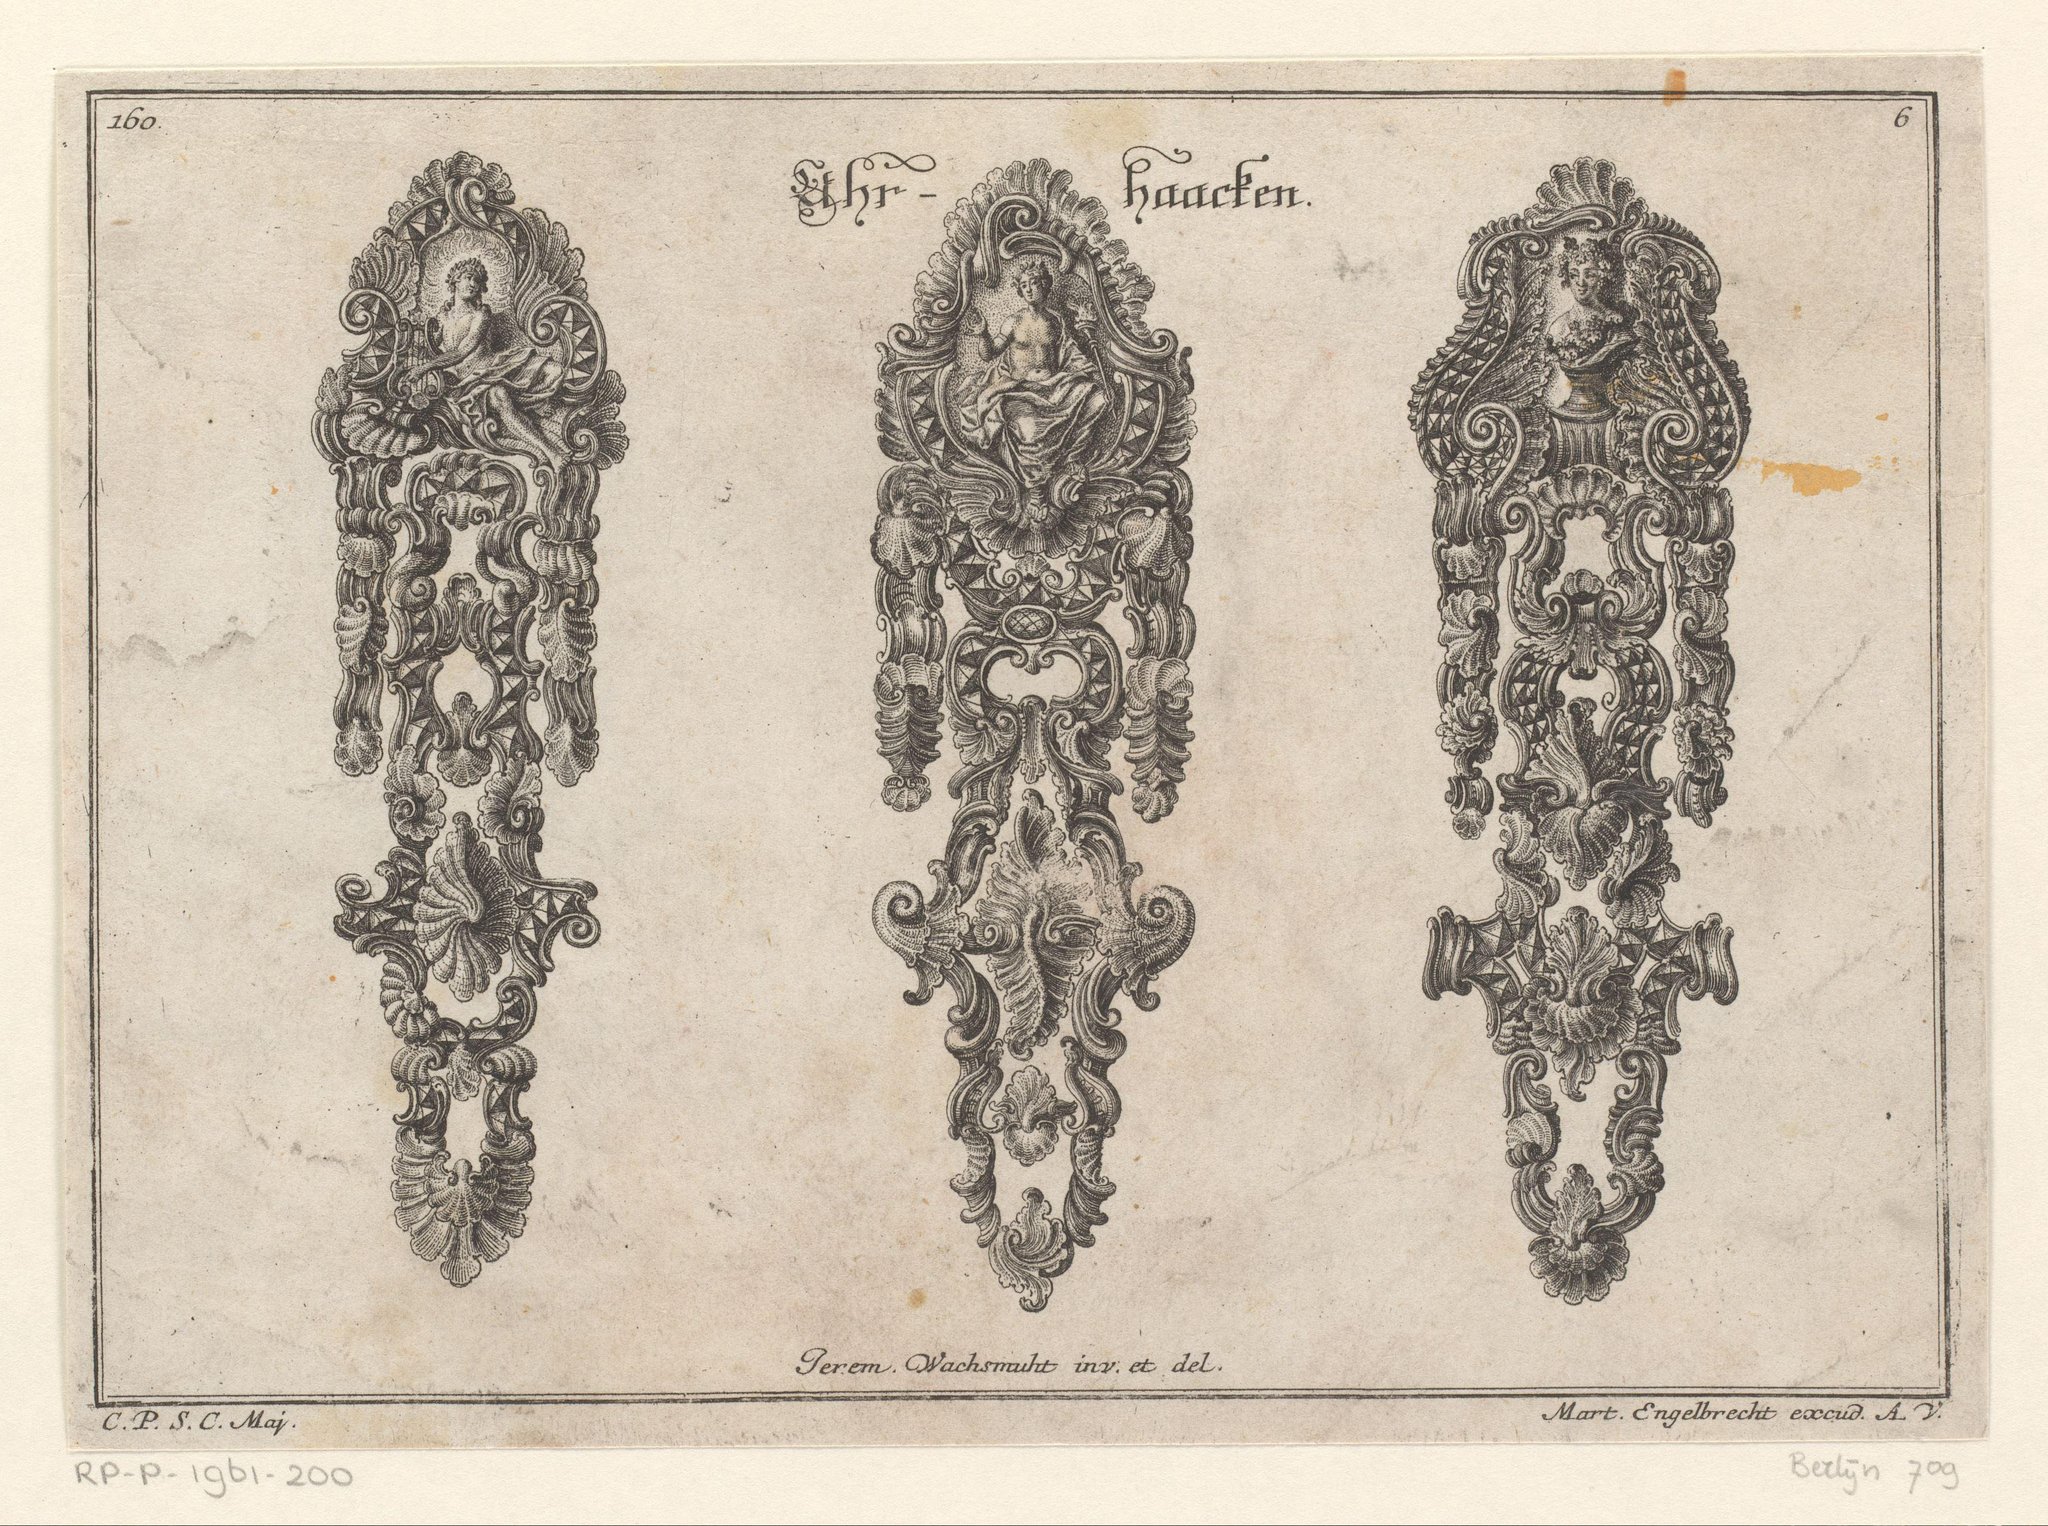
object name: print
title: Gevesten en haken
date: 1721-1756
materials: paper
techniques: etching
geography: augsburg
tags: torch, (story of) bacchus (dionysus), liber, (story of) apollo (phoebus)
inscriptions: collector's mark: Lugt 2228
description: Drie geornamenteerde horlogehaken. Links met Apollo, in het midden met een figuur met fakkel, rechts met een buste van Bacchus. Prentnummer 160.